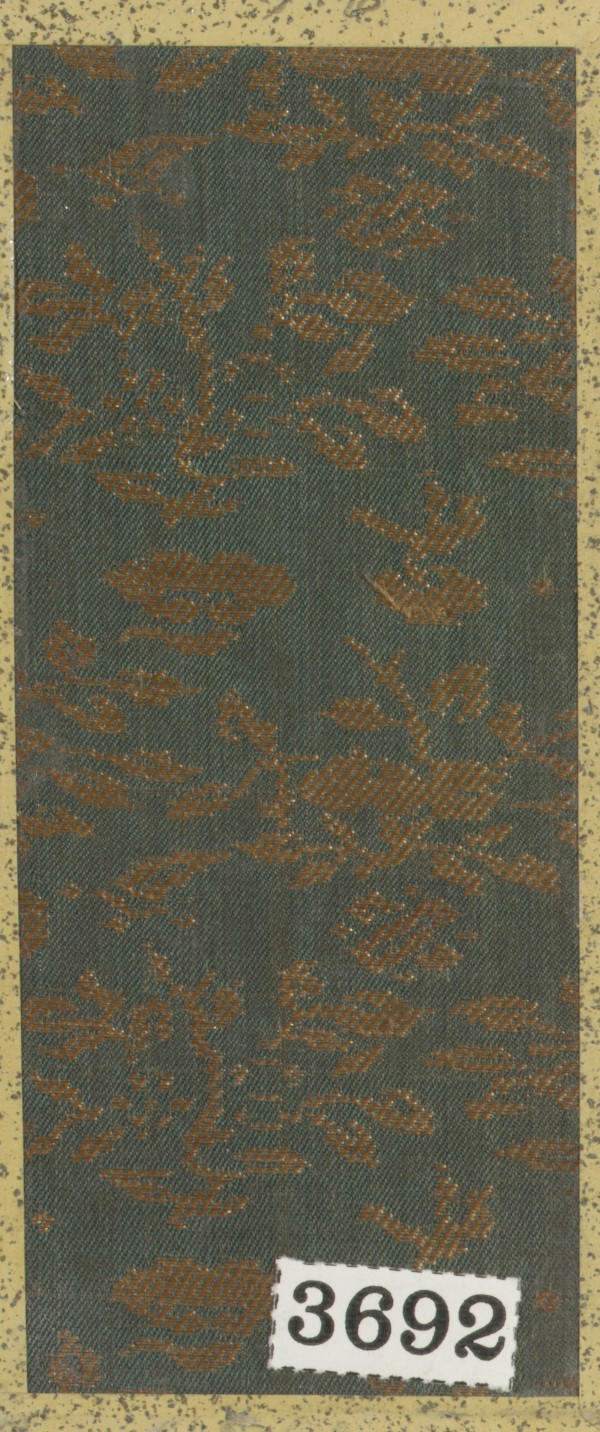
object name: sample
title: Textile Sample from Sample Book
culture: japanese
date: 1801-1900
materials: silk